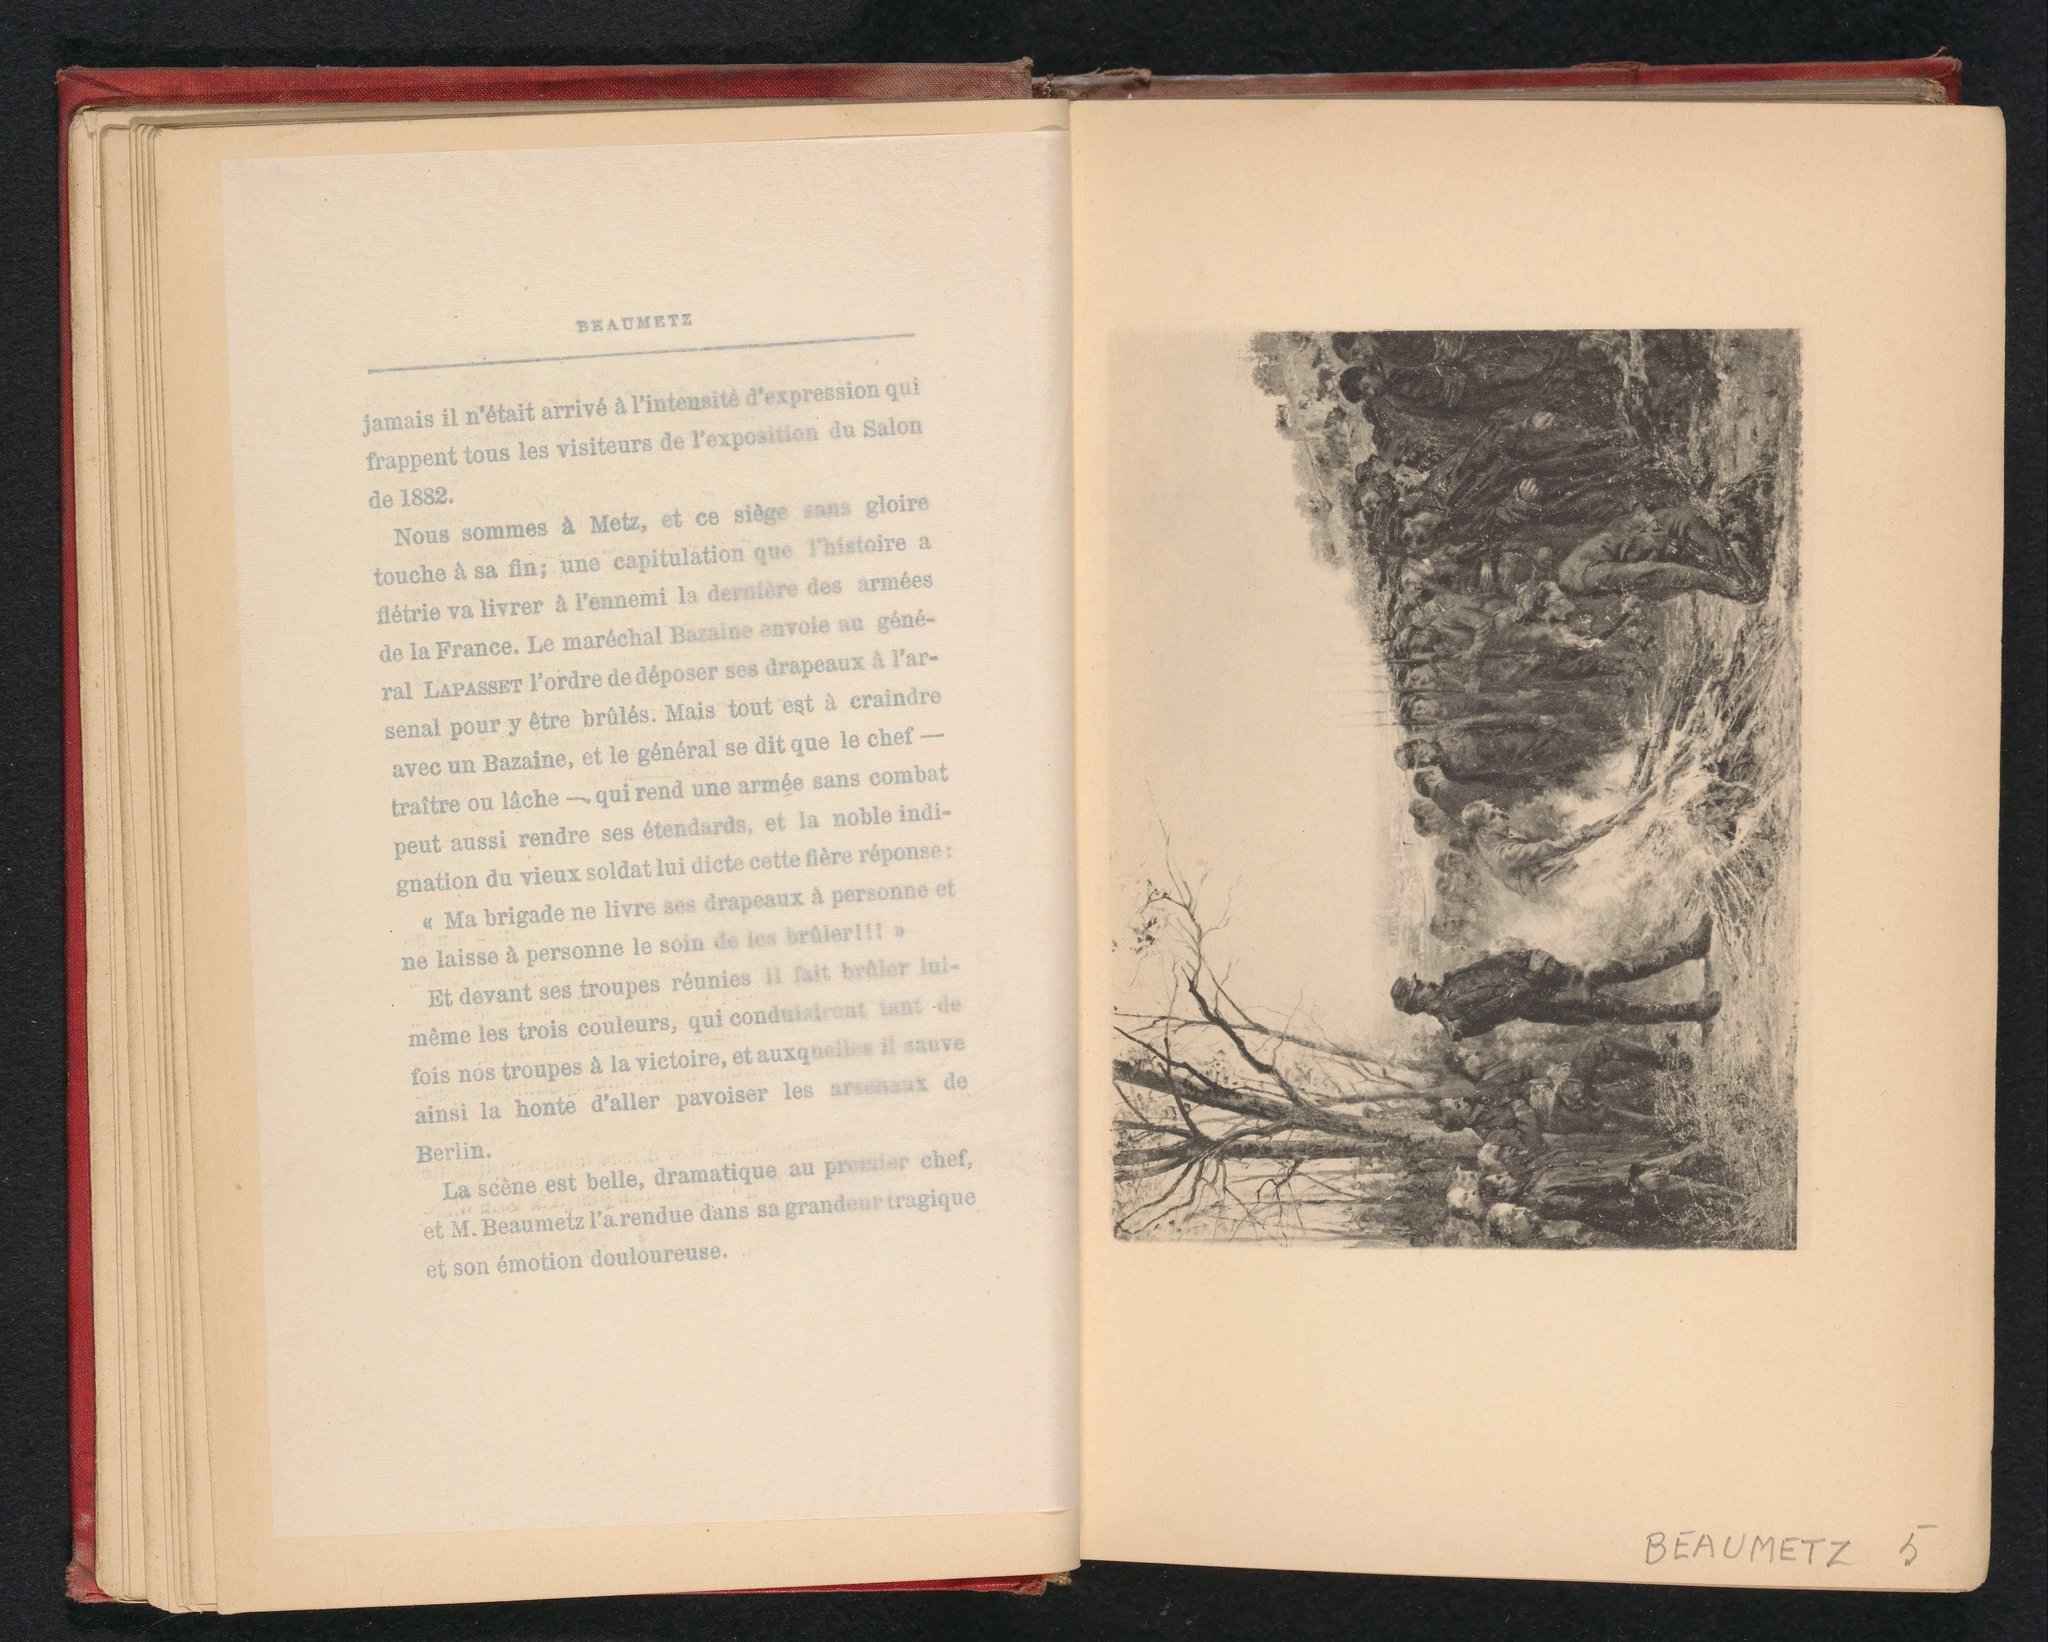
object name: page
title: Fotoreproductie van een schilderij, voorstellende de capitulatie van het Franse leger te Metz tijdens de Frans-Pruisische oorlog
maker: étienne dujardin-beaumetz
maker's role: painter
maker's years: 1852-1913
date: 1872-1882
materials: paper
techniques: photograph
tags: capitulation, the defeated before the victor, surrender ~ war